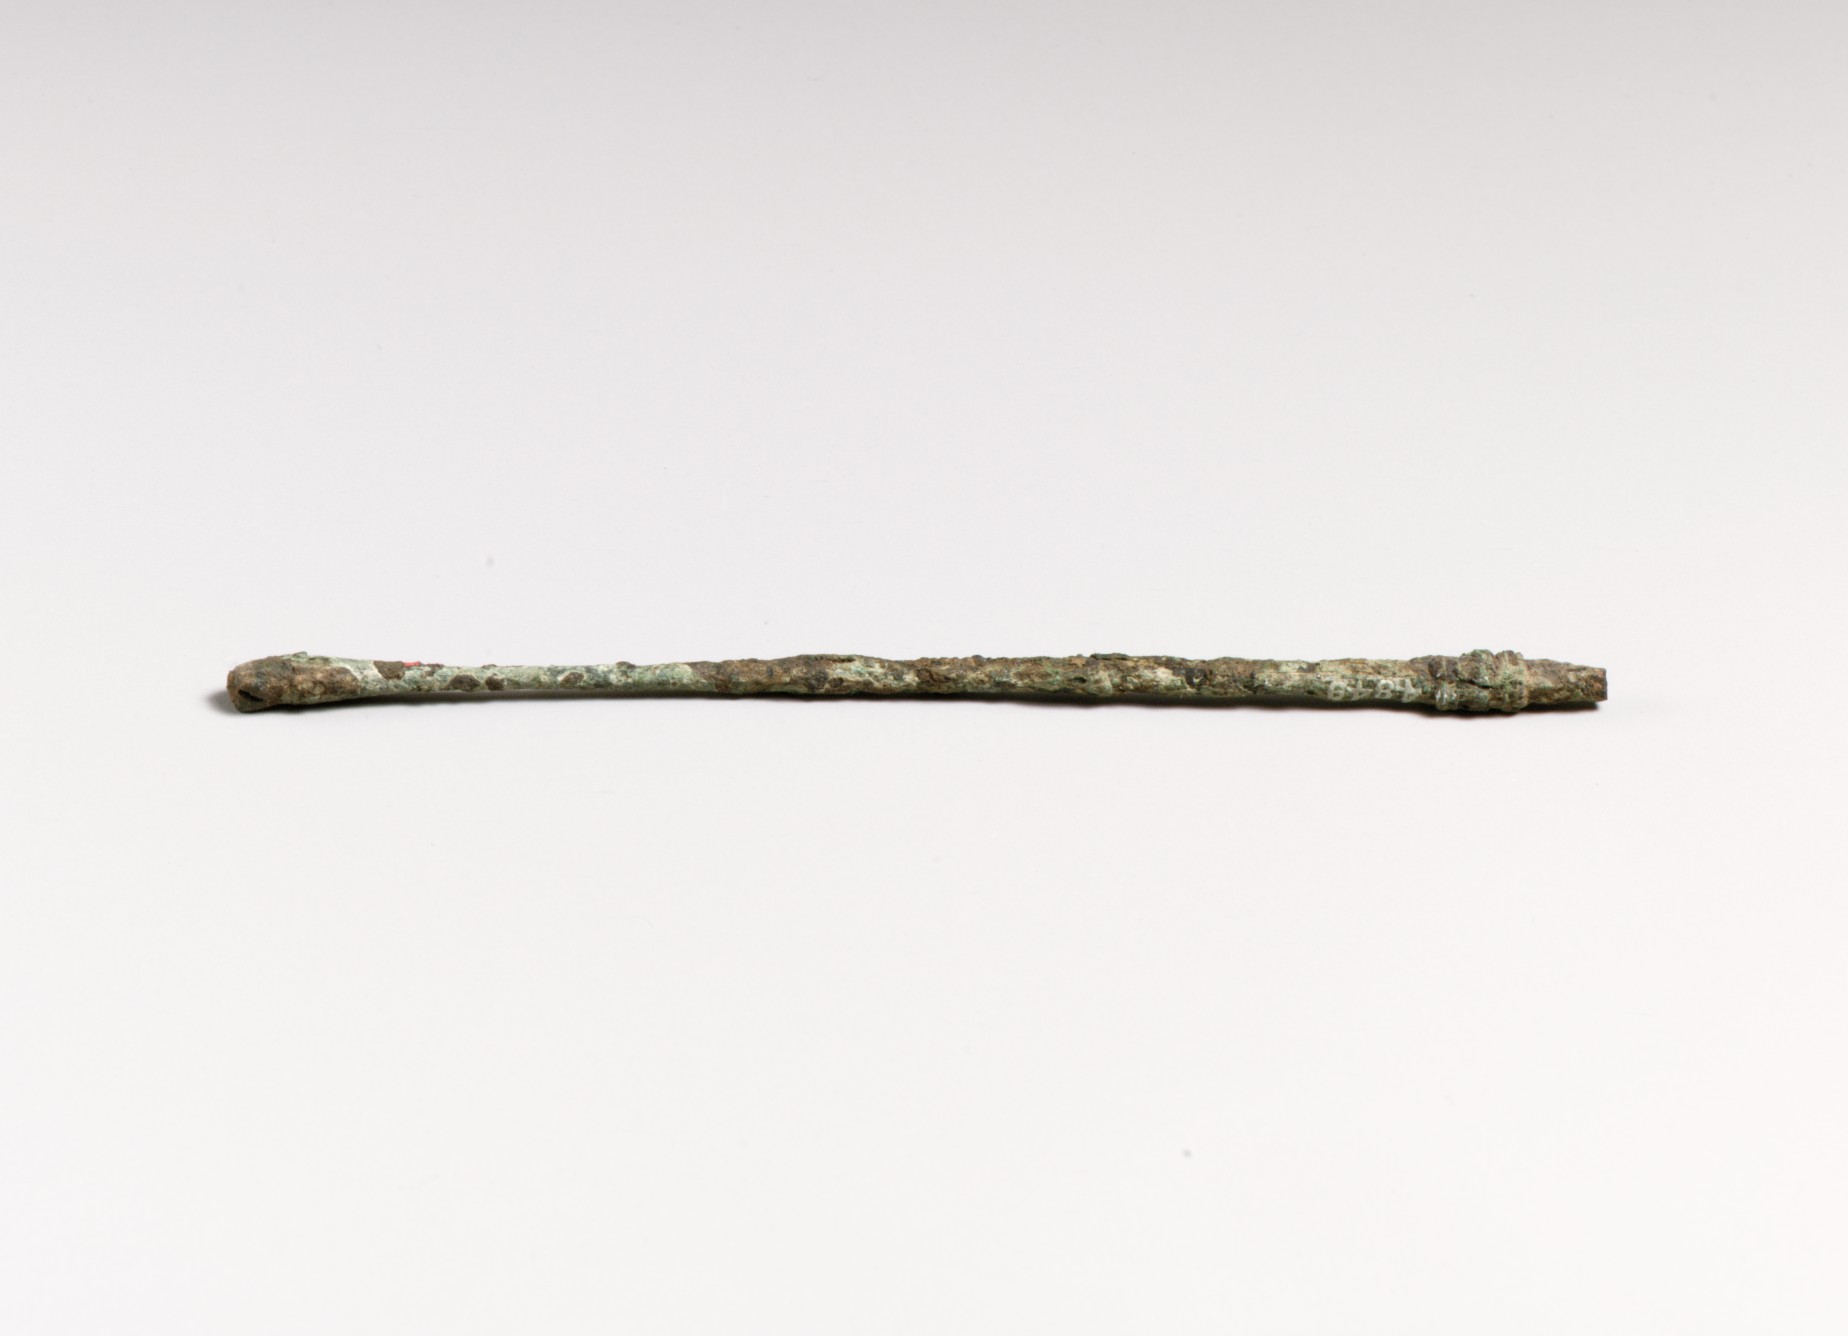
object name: probe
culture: cypriot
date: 3900 BCE-100 CE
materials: bronze